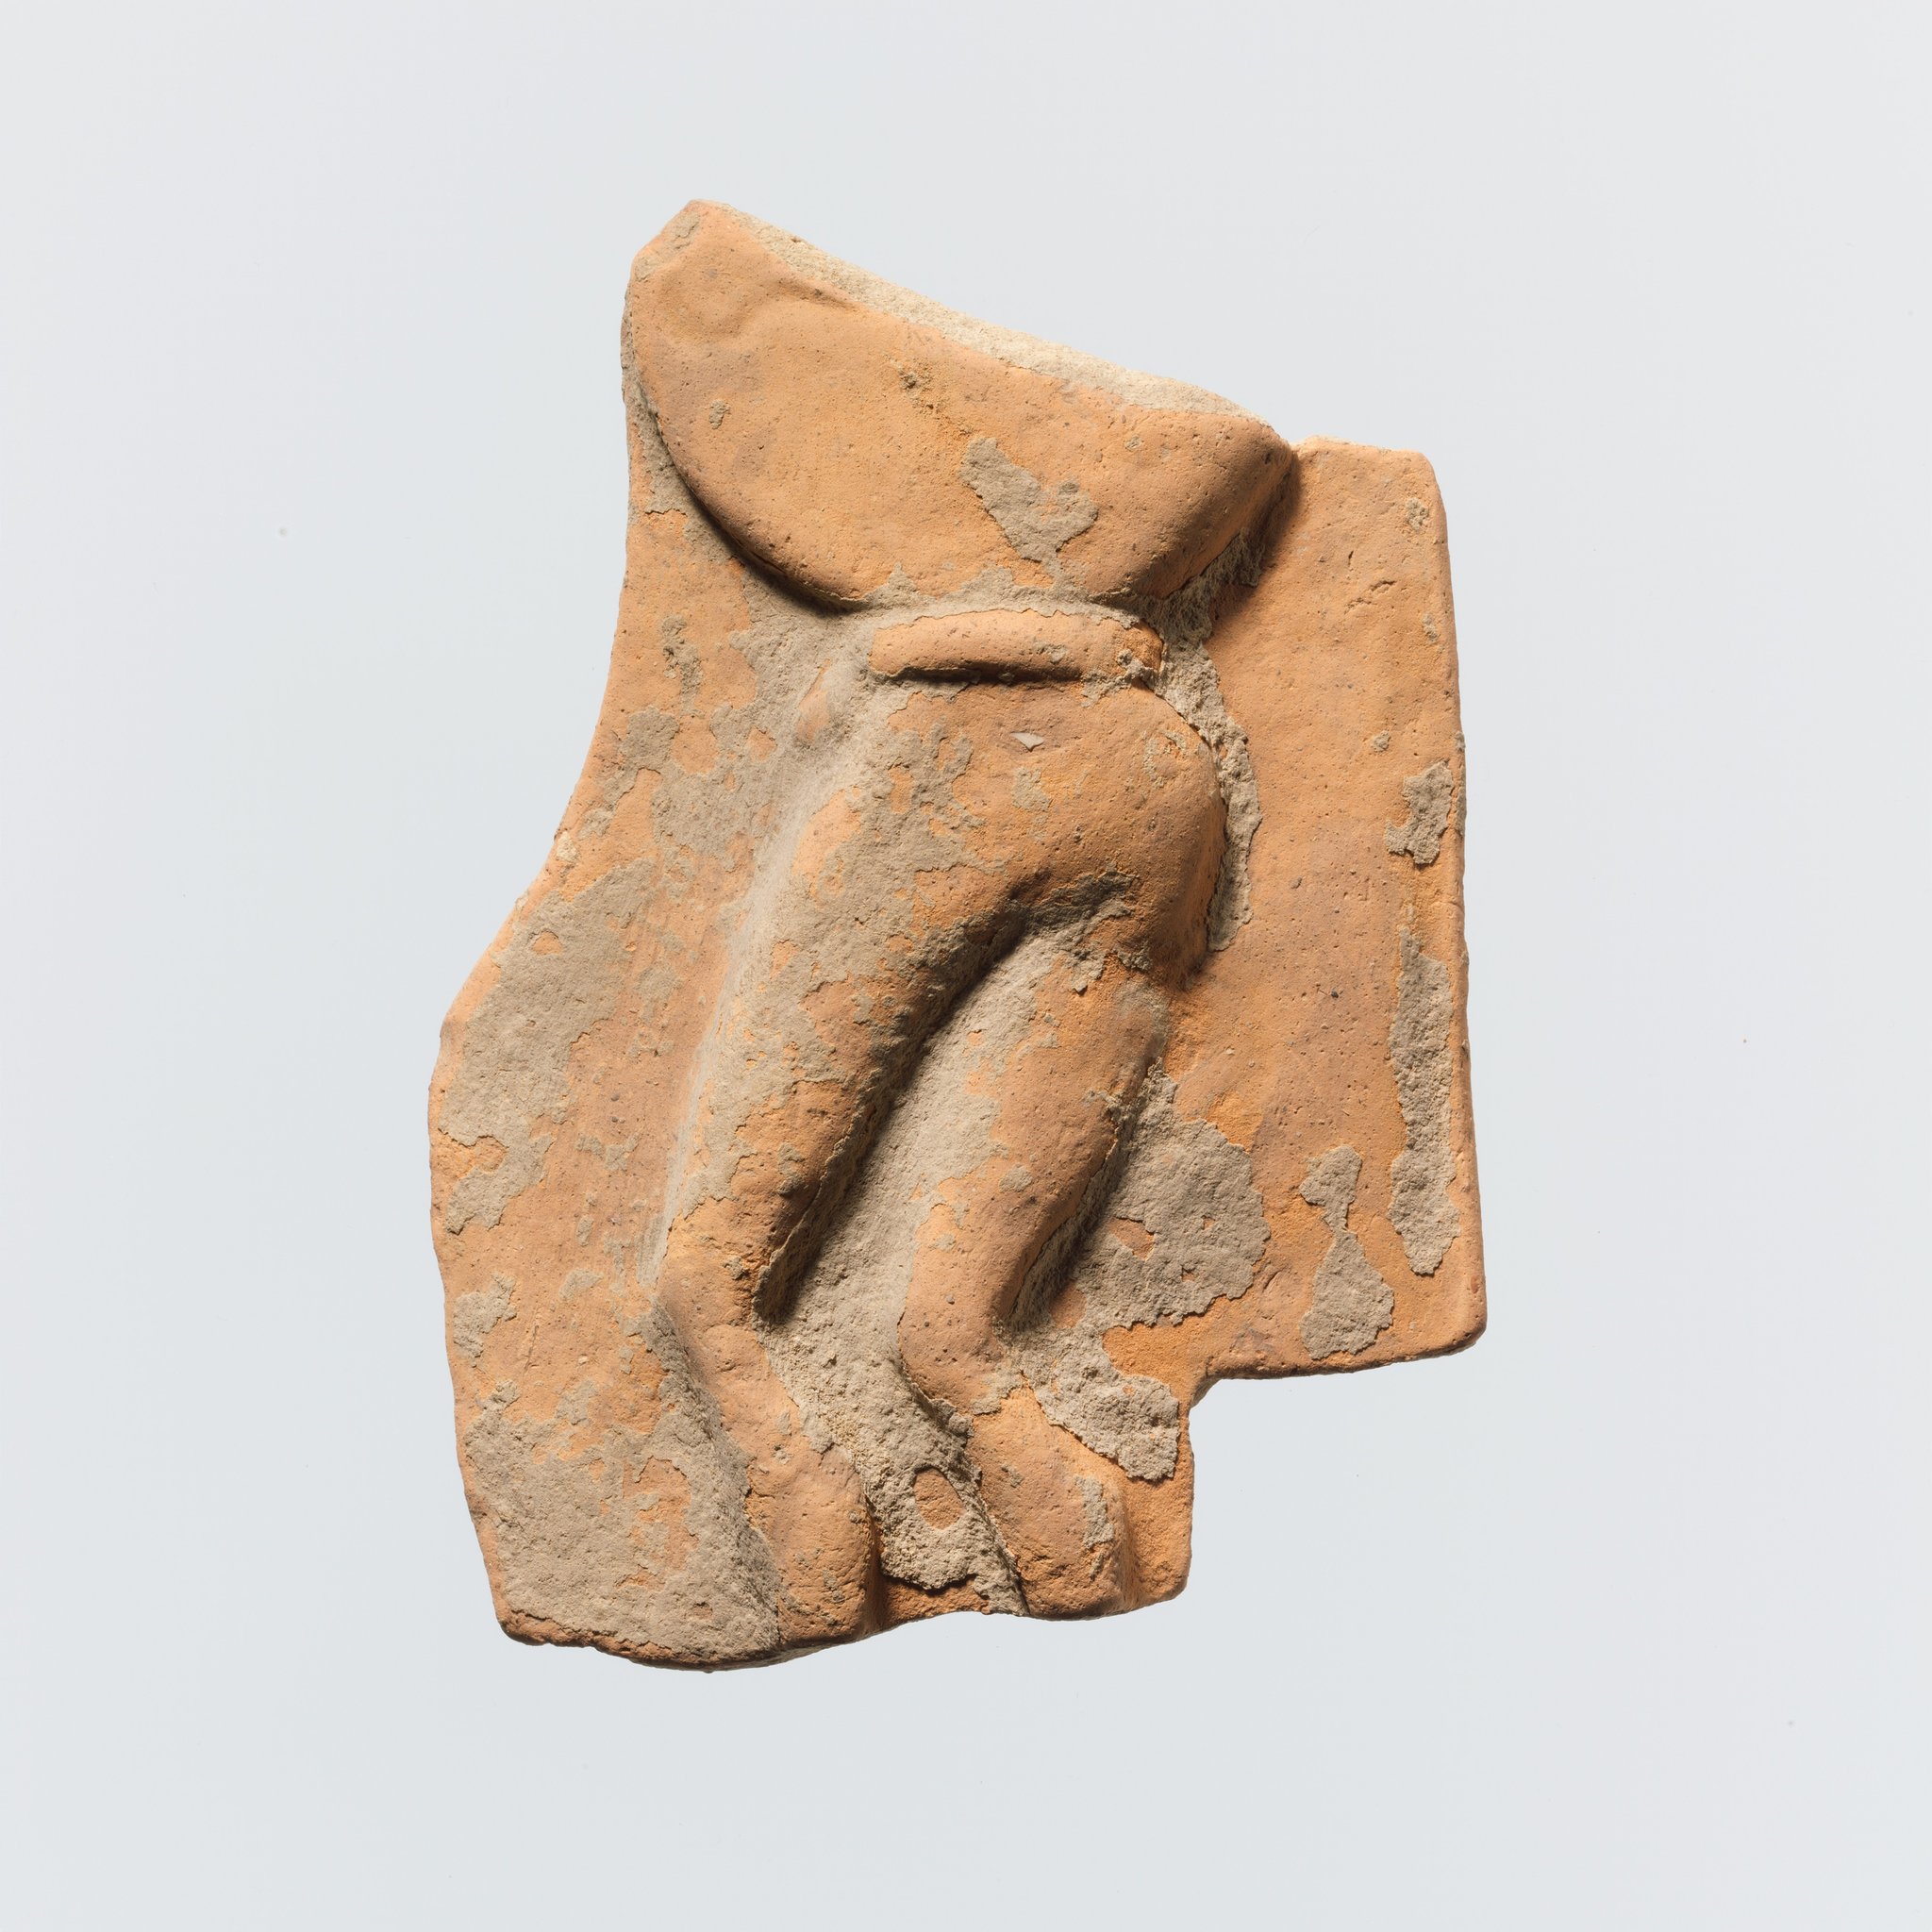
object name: pinax, warrior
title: Fragment of a terrracotta plaque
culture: greek, cretan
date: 700-601 BCE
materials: terracotta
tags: warriors